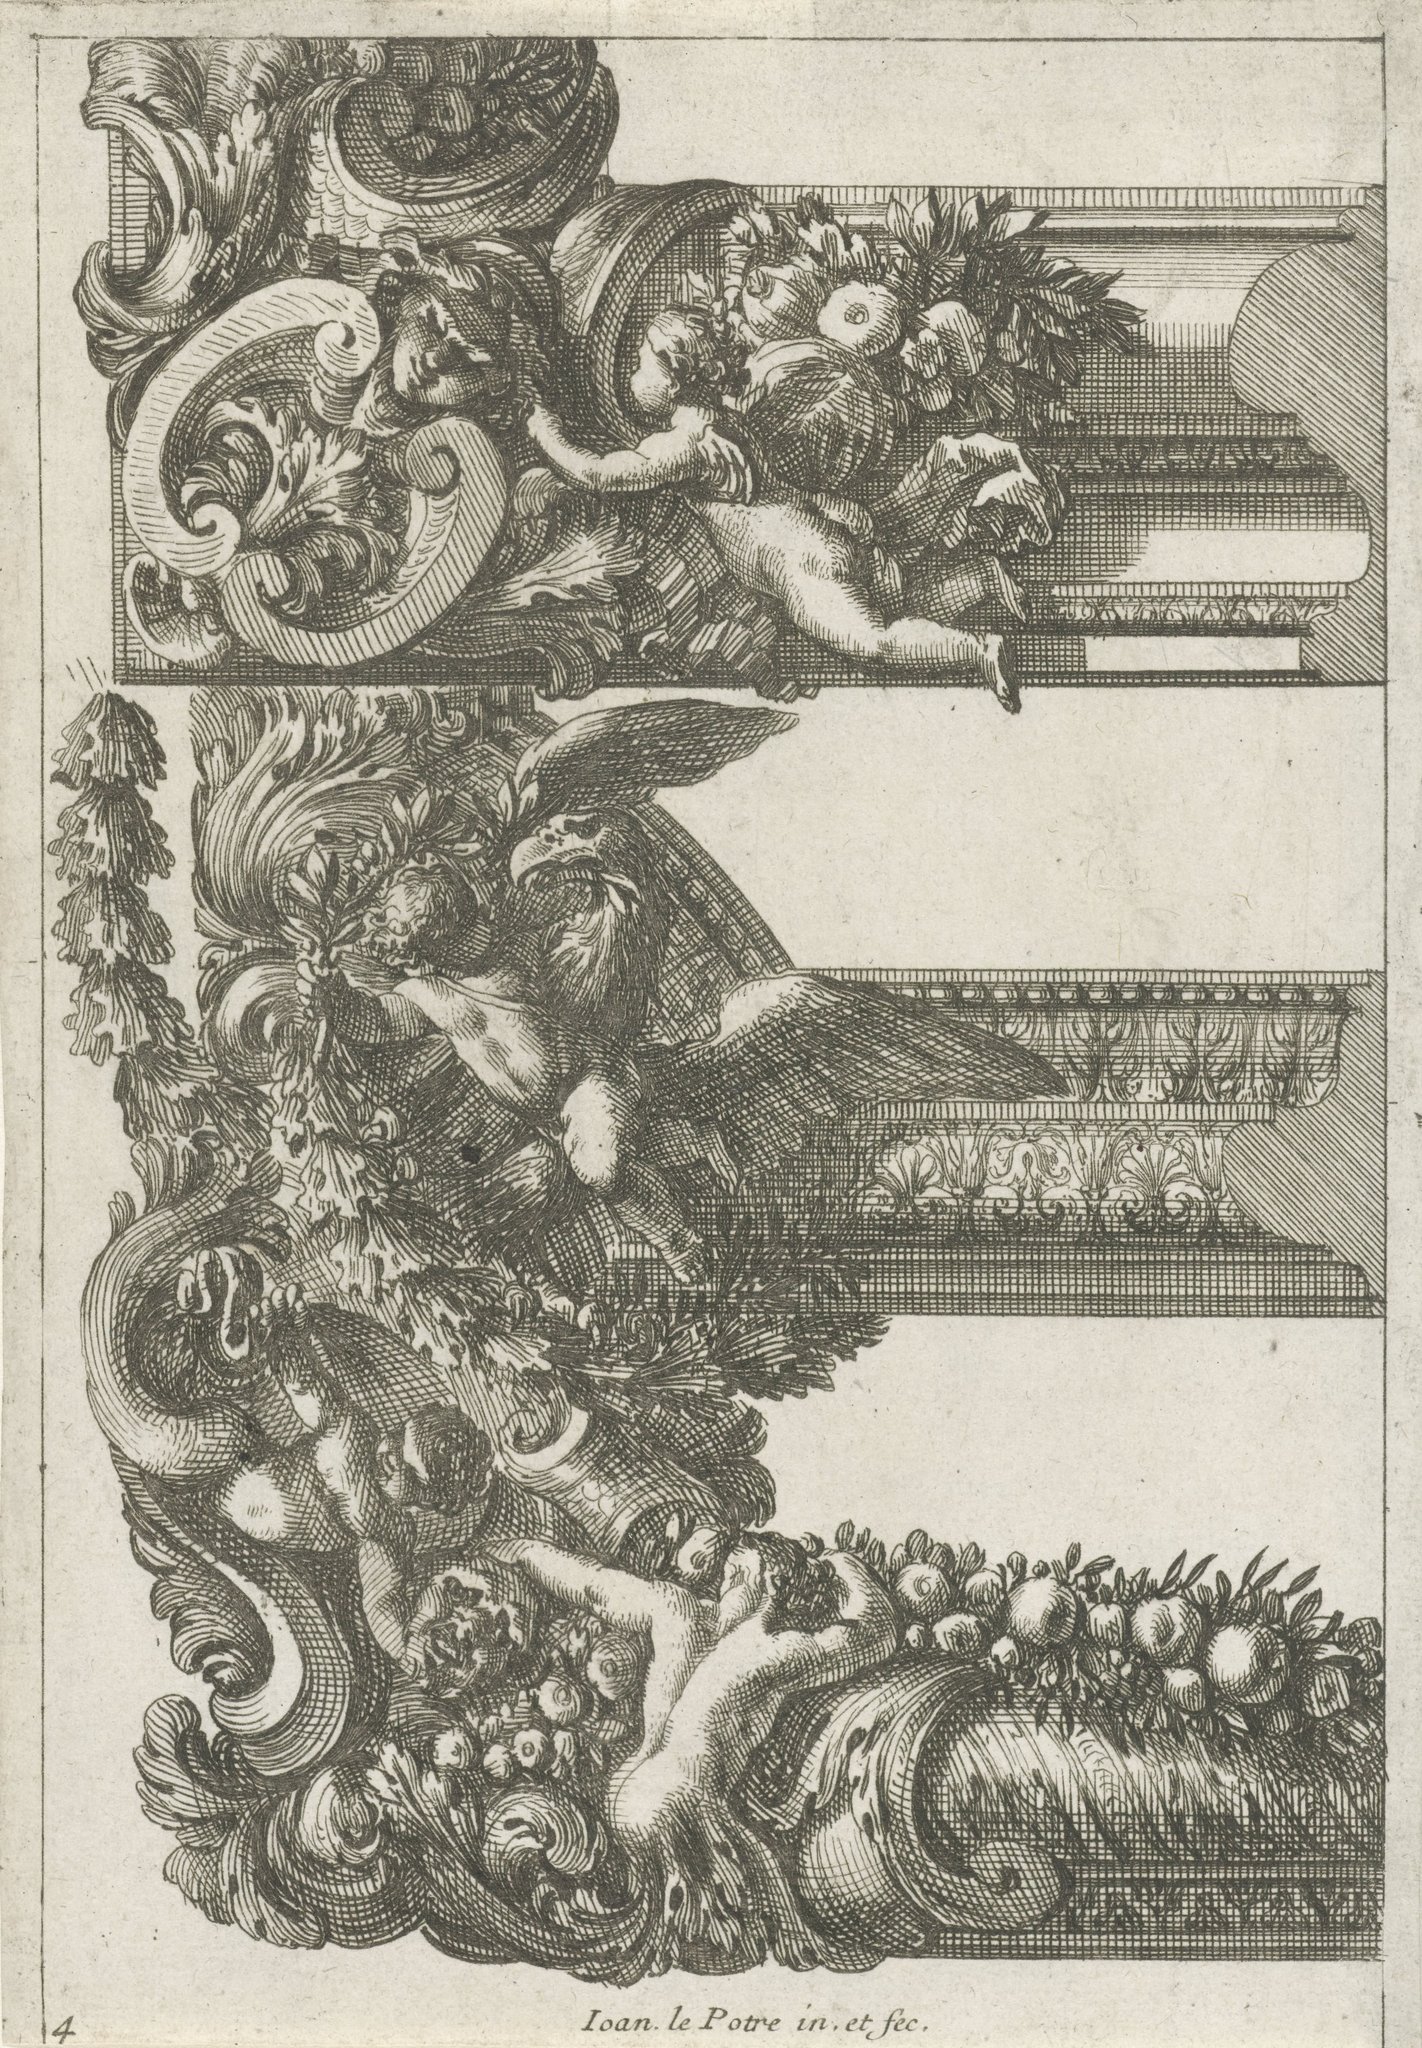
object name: ornament print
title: Bordures de Tableau a la Romaine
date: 1655-1657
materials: paper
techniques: etching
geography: paris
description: Gedecoreerd met putti, bladeren en fruitguirlandes. Uit eerste editie.